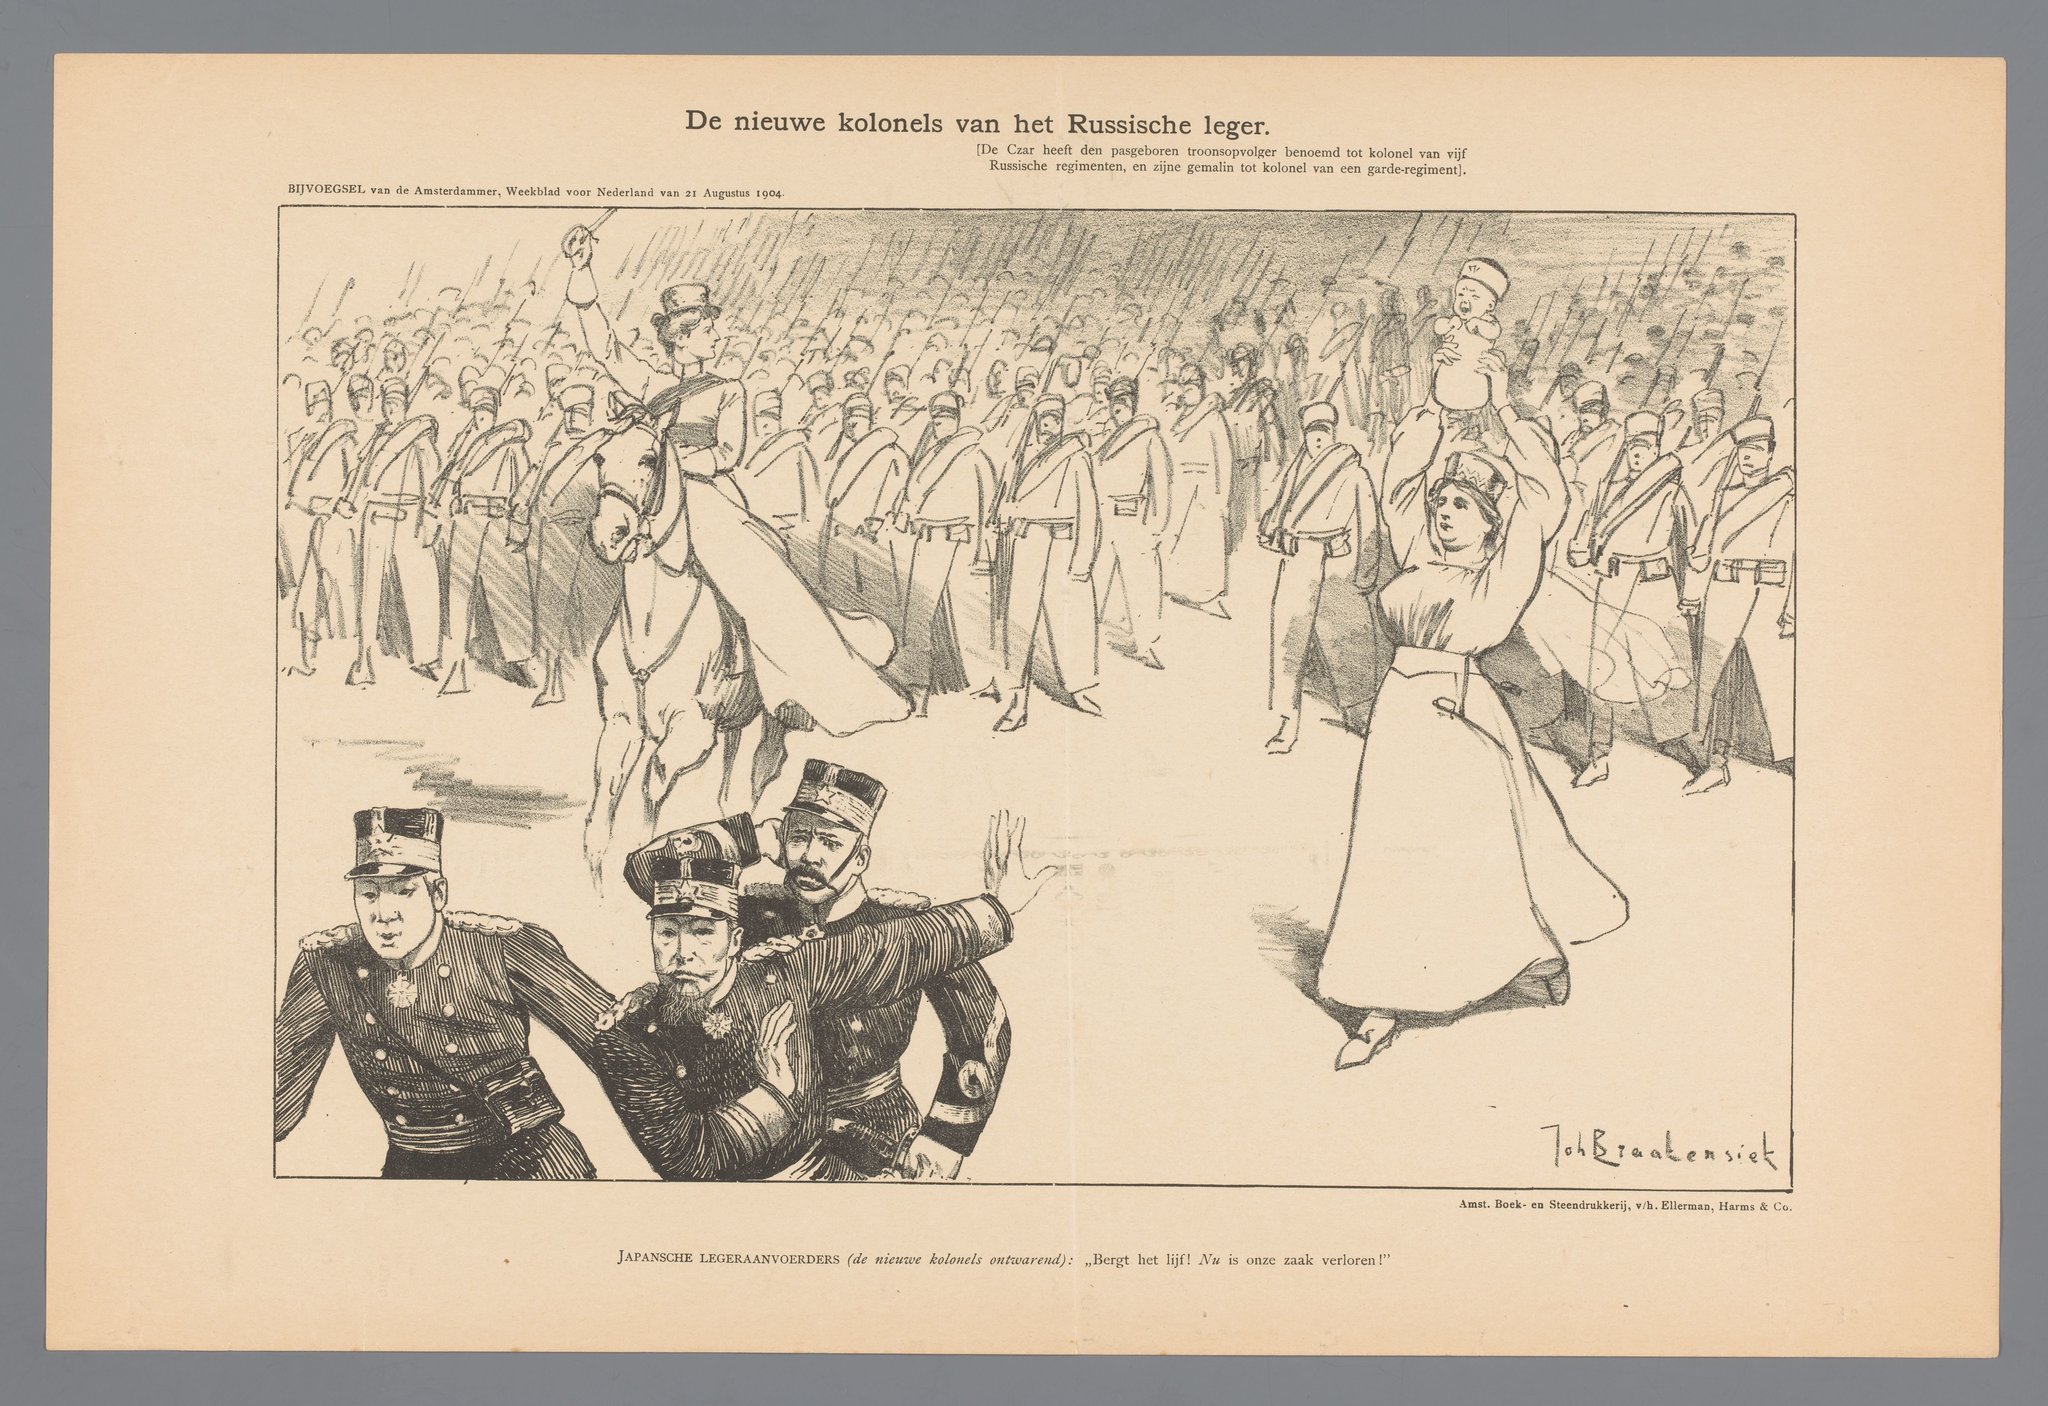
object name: cartoon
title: De nieuwe kolonels van het Russische leger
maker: johan braakensiek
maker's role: draughtsman, print maker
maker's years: 1858-1940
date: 1904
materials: paper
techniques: lithograph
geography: amsterdam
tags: war, political caricatures and satires, russia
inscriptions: date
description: Prent uit het bijvoegsel van: De Amsterdammer. Weekblad voor Nederland, 21 augustus 1904.